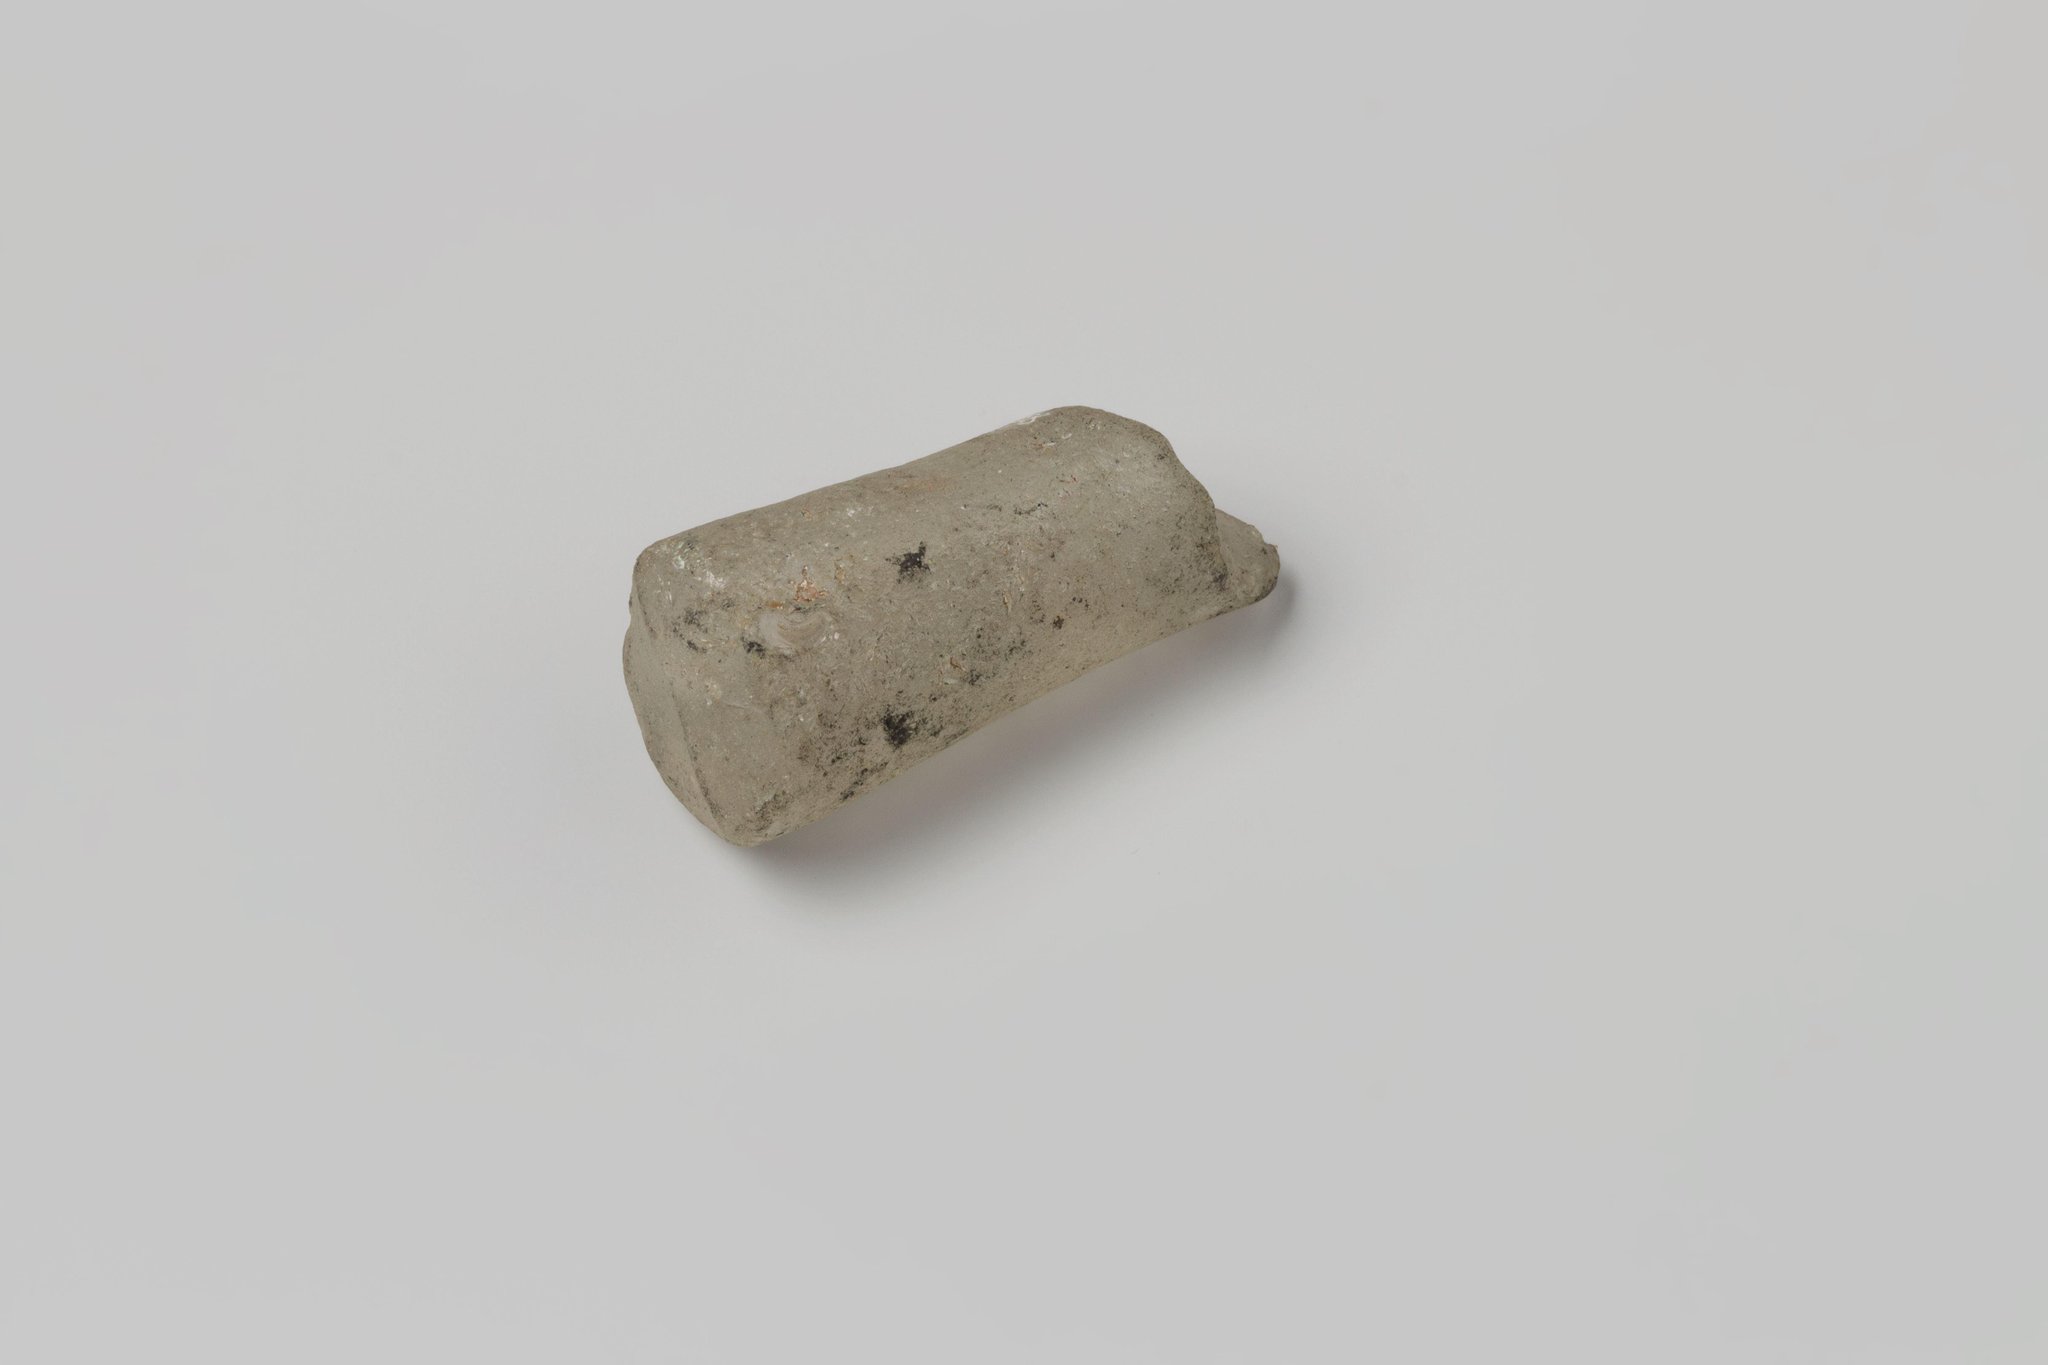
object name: helve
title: Fragment rechte steel van glas uit het wrak van de Oost-Indiëvaarder Hollandia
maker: Anonymous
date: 1700-1743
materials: glass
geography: netherlands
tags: verenigde oostindische compagnie, hollandia (schip), annet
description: Glass, stem glass, stems, plain; fragm, circular, tapering, hollow core, eroded.